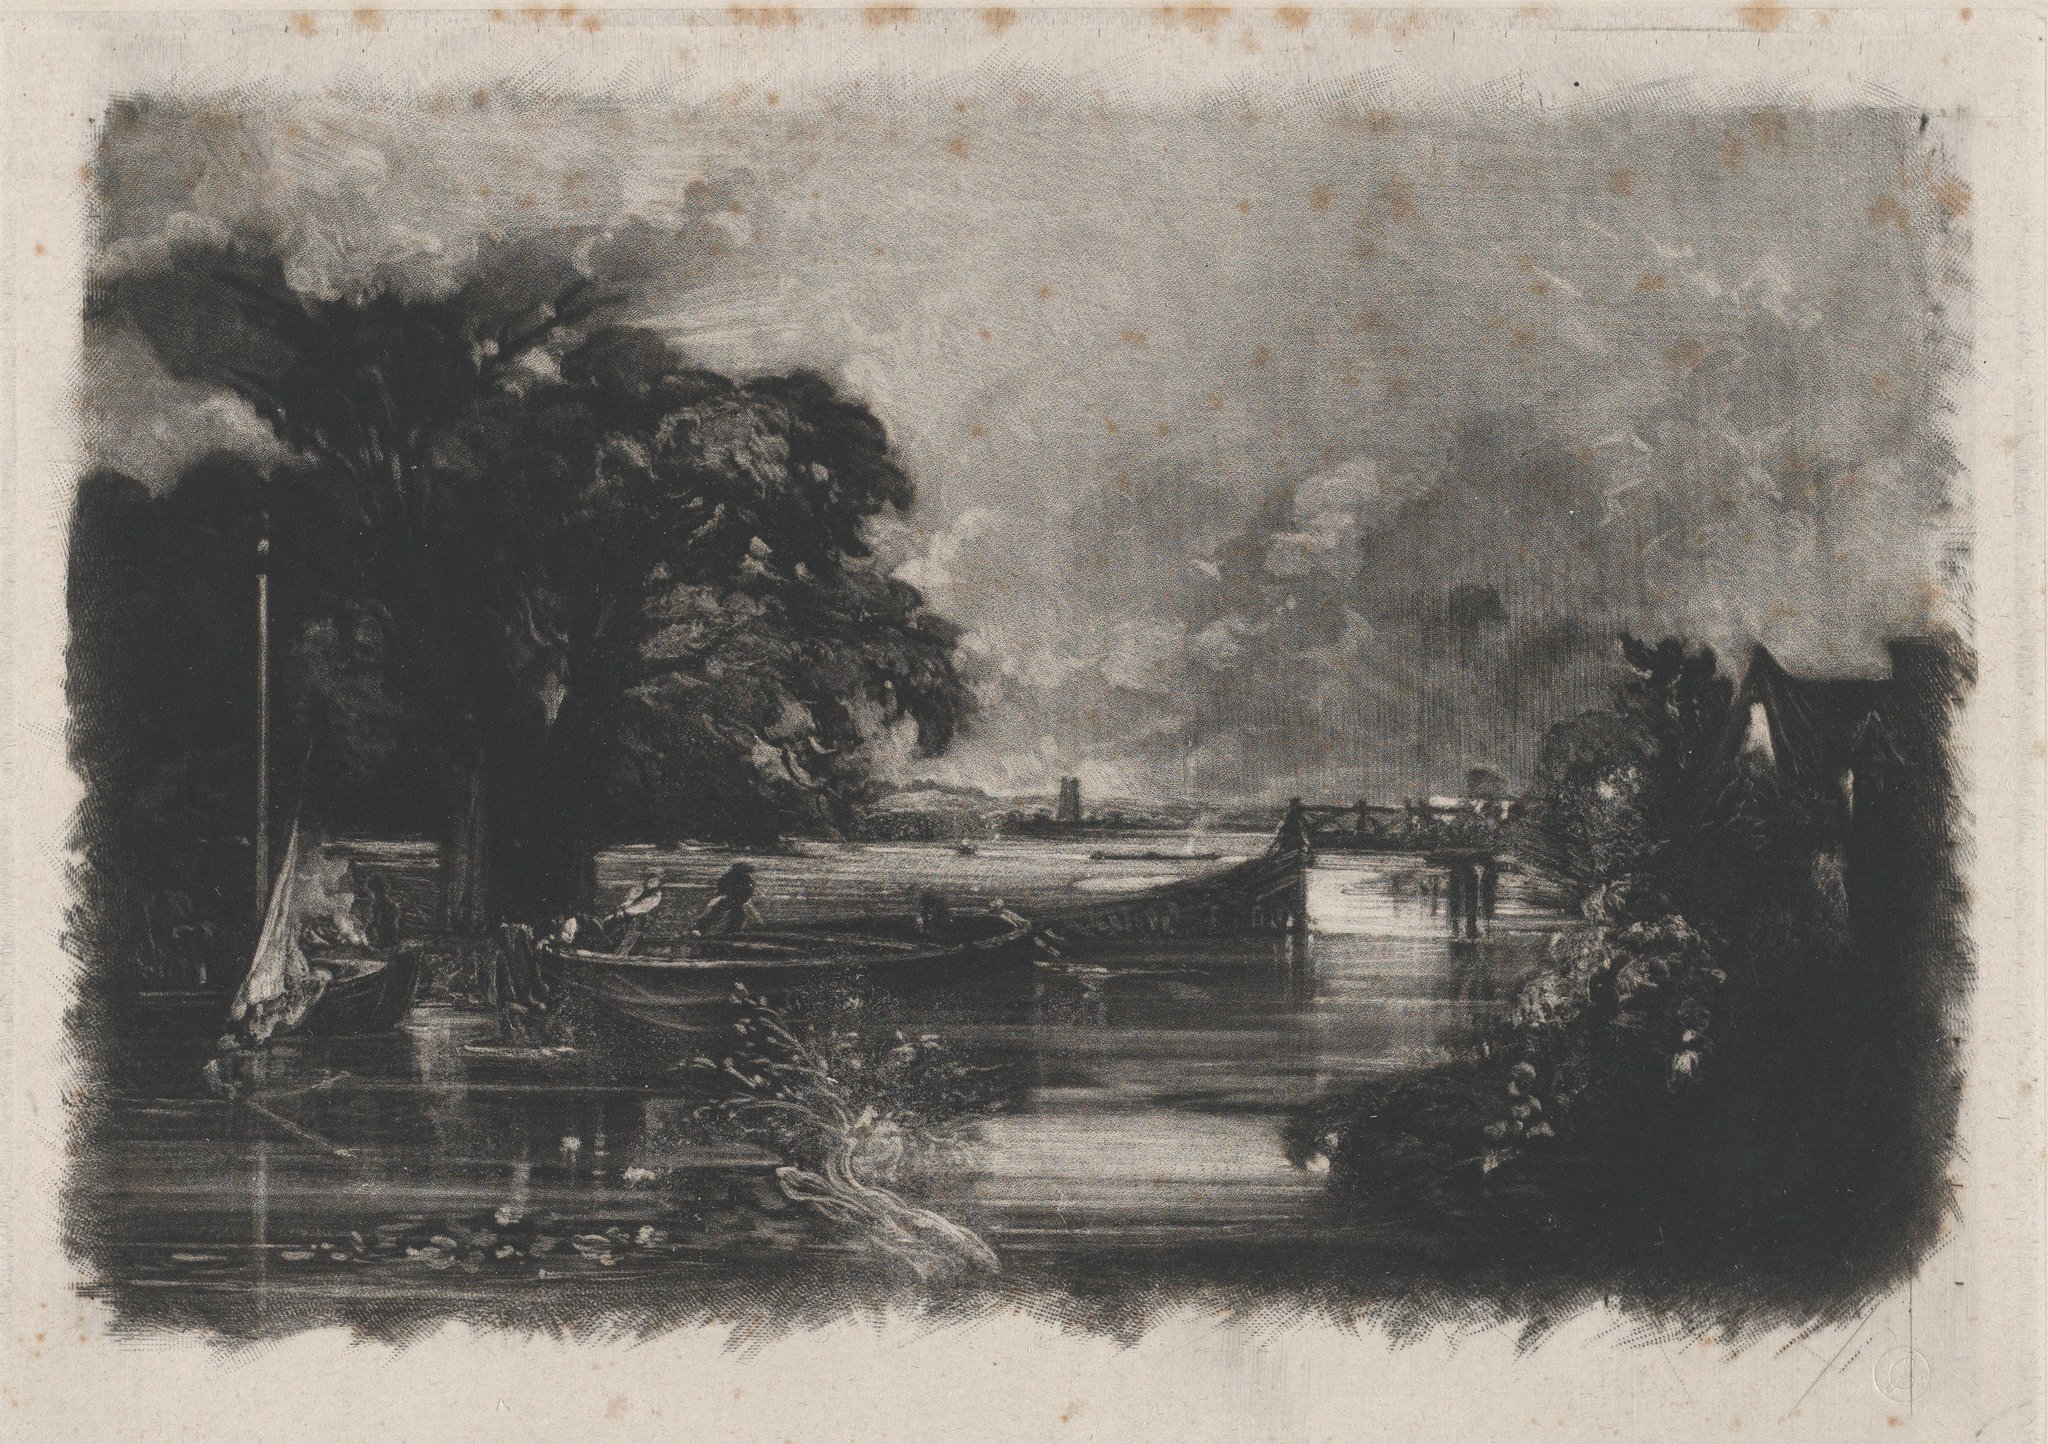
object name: print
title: River Stour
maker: david lucas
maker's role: artist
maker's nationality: british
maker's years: 1802-1881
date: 1830-1831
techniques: printmaking, mezzotint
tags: rivers,trees,boats